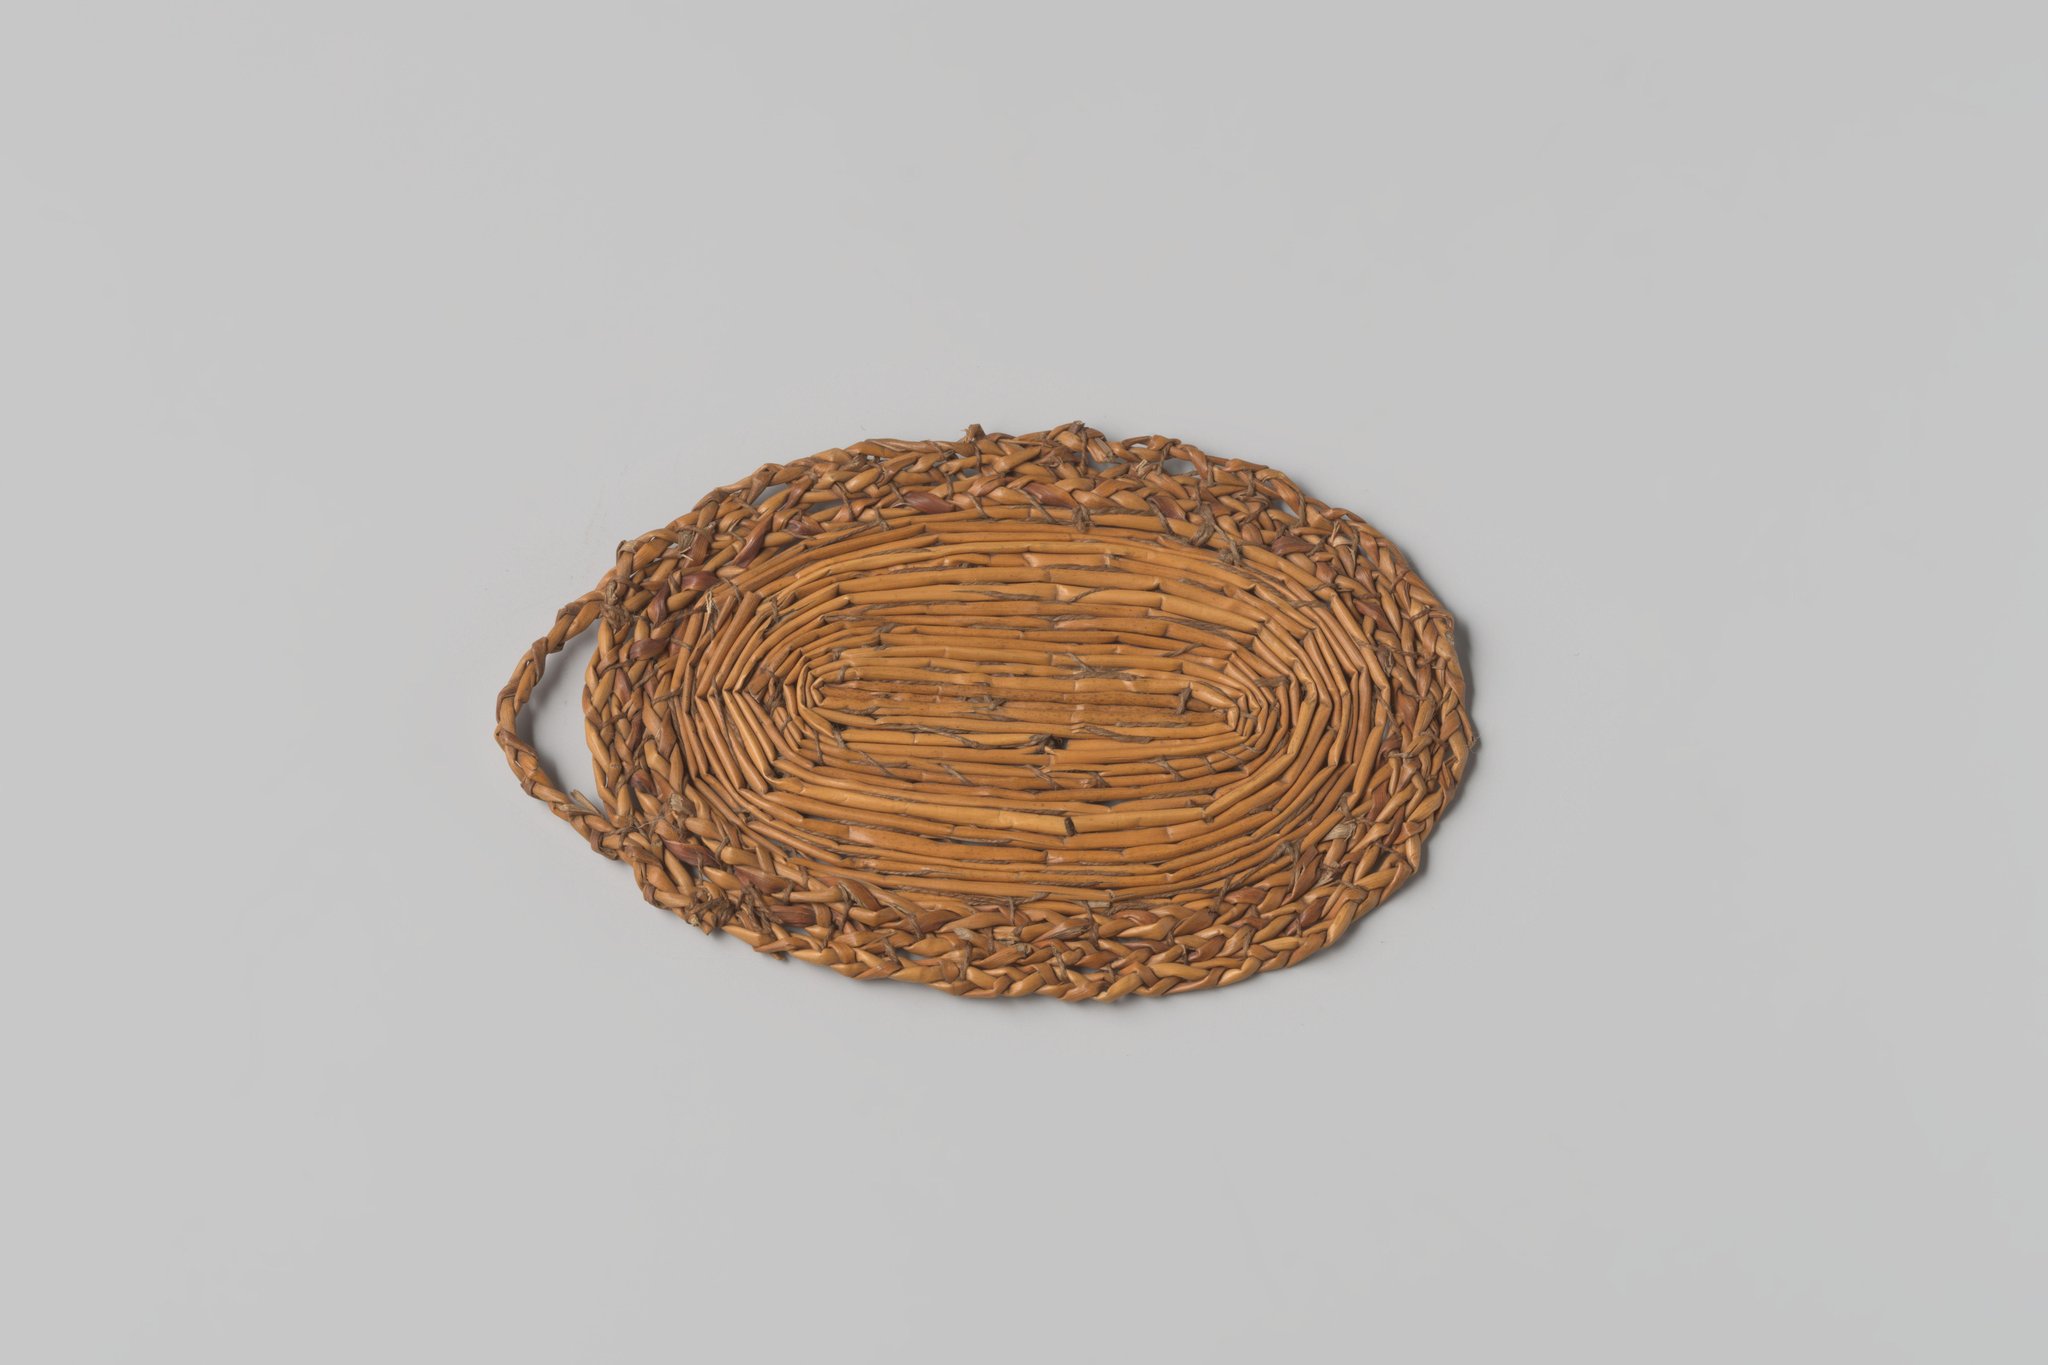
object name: miniature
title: Vloermat, ovaal, van mattenbies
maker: Anonymous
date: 1600-1699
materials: linen, fiber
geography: netherlands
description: Vloermat, ovaal, van mattenbies. Vervaardigd uit één lange vlecht die rondom doorlopend met linnen draad is vastgezet. Aan het einde is een handvat opengelaten.